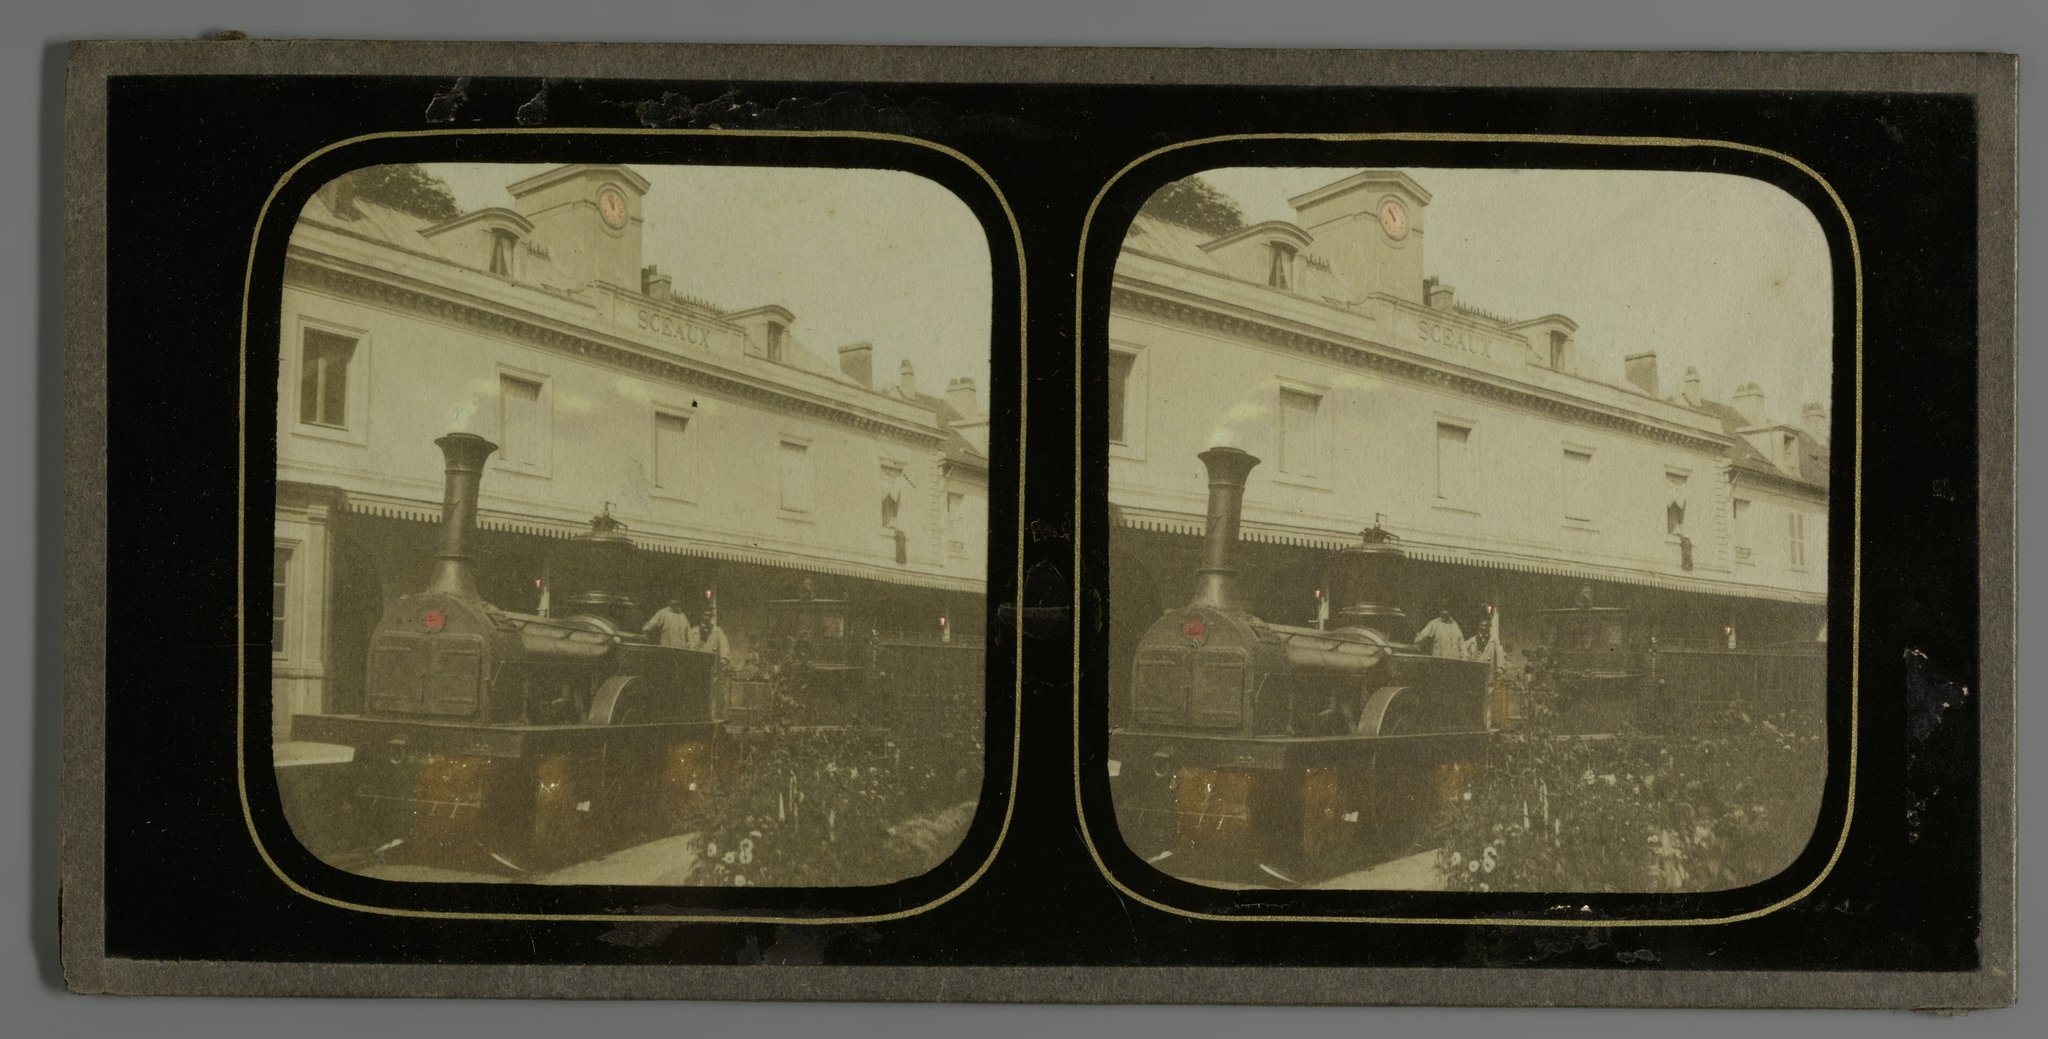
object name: stereoscopic photograph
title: Stoomlocmotief voor het stationsgebouw te Sceaux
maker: Anonymous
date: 1850-1880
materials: cardboard, glass, paper, photographic support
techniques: albumen print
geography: sceaux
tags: railway, train, station; shelter (railway, tramway)